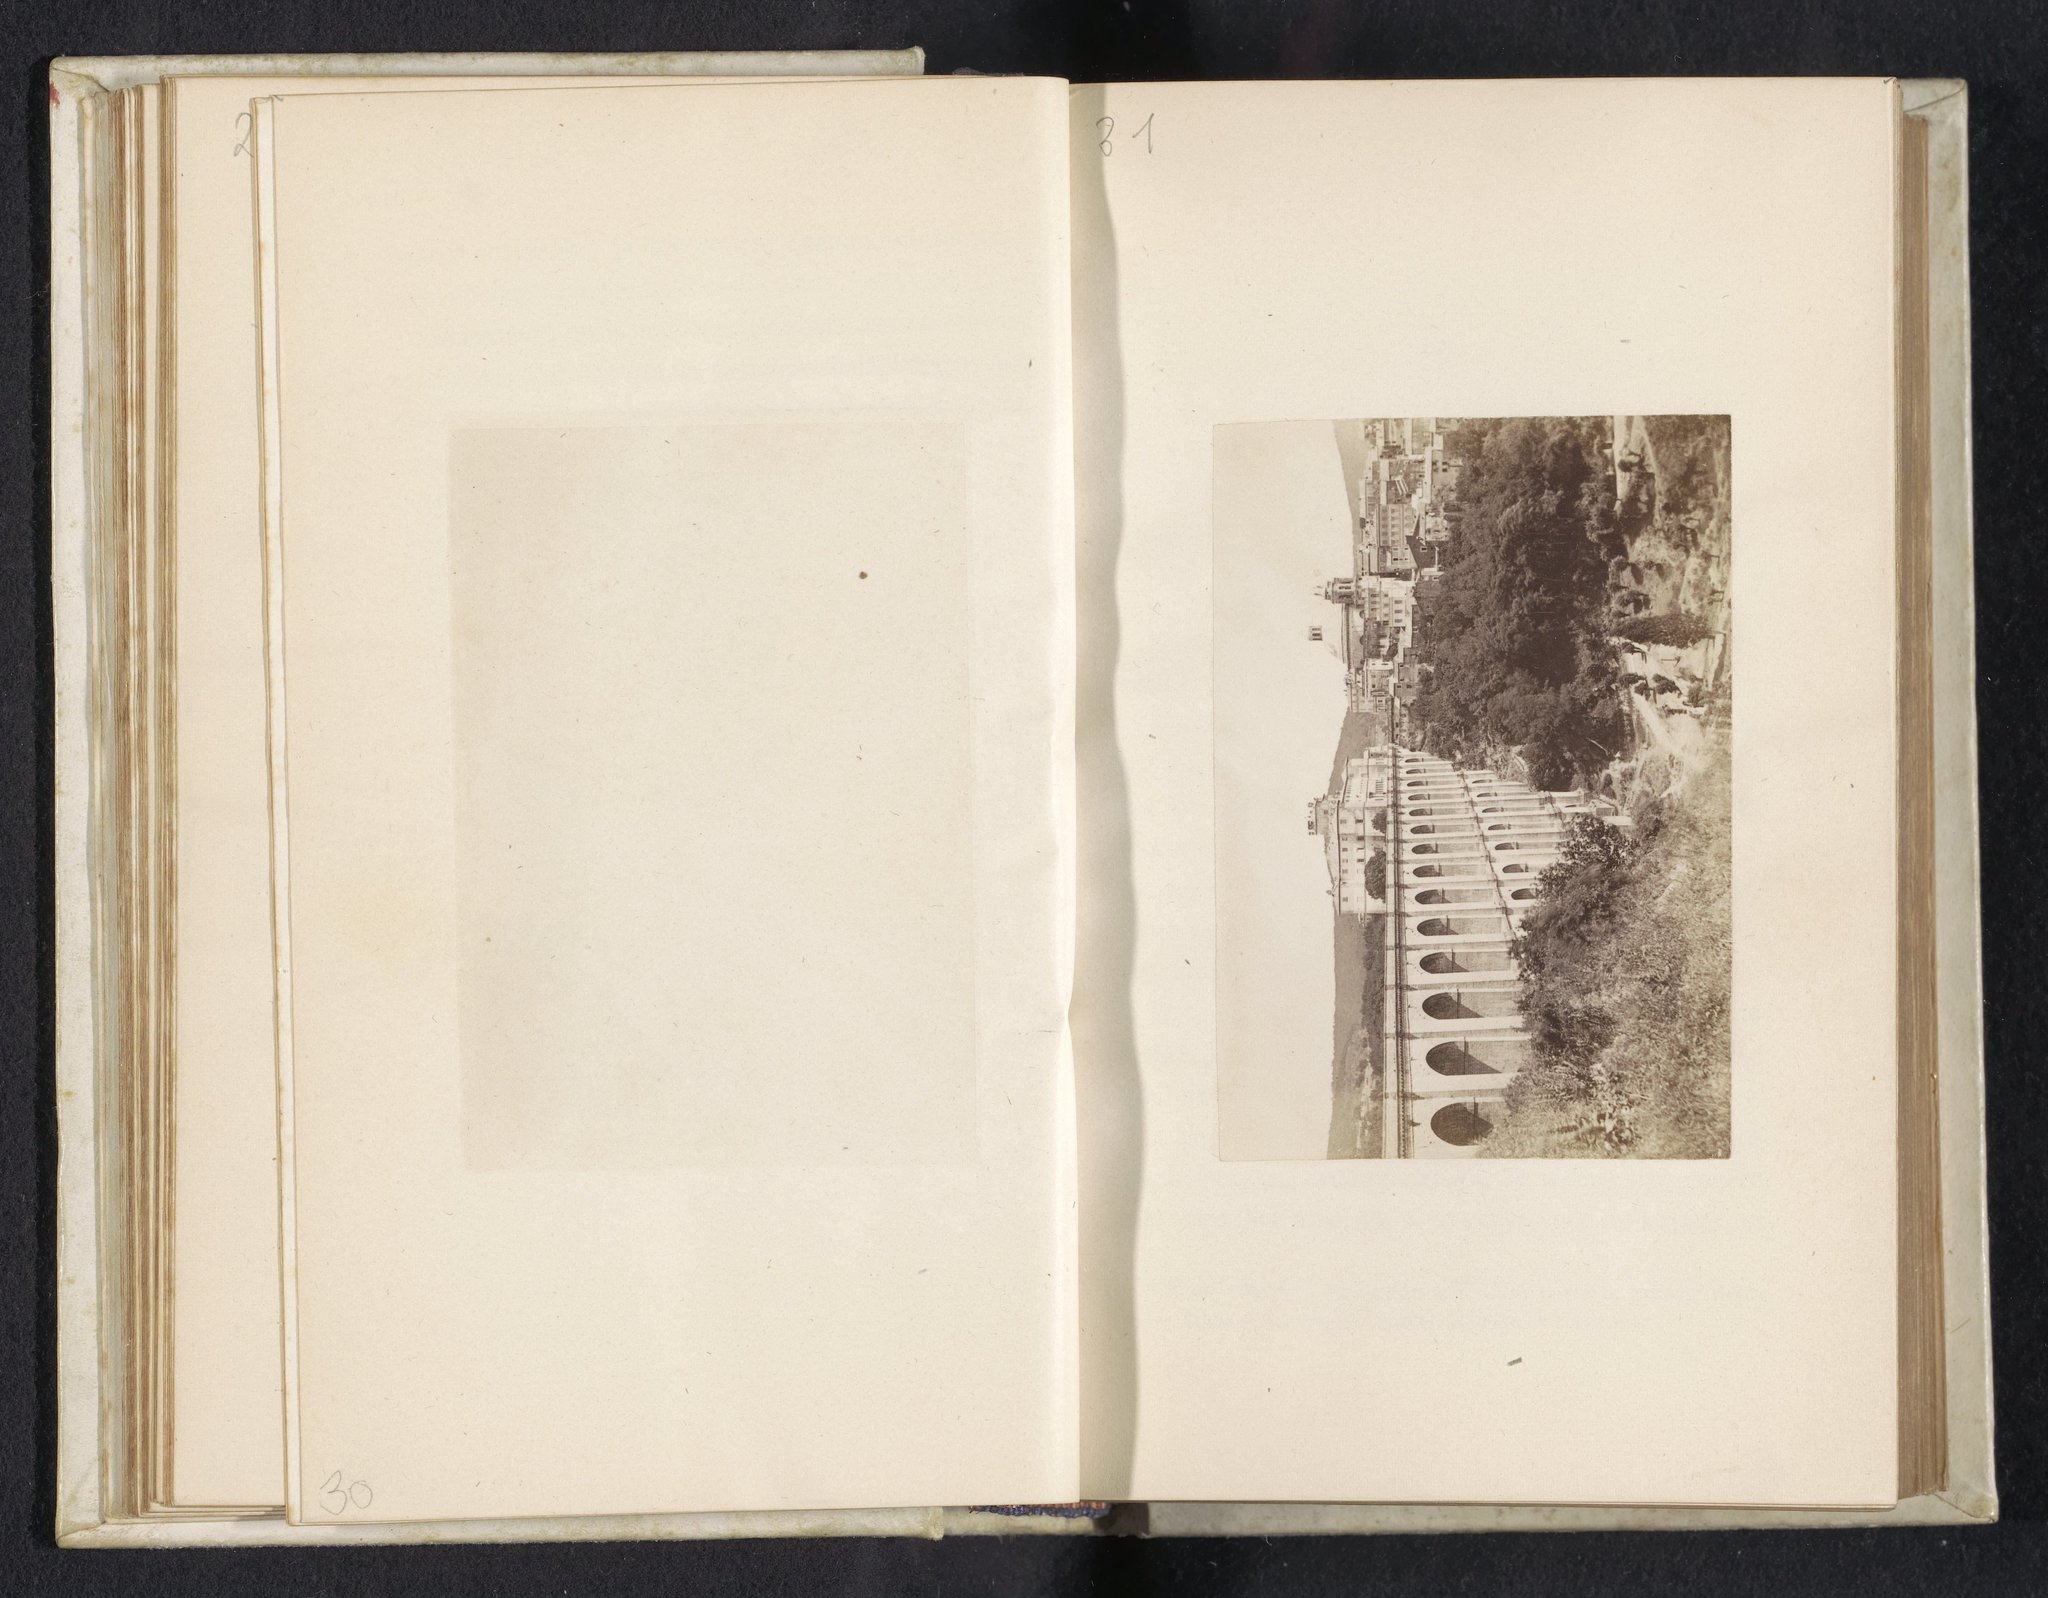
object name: photograph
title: Gezicht op Ariccia, met op de voorgrond een aquaduct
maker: Anonymous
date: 1850-1860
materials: photographic support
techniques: albumen print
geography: lazio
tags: city-view in general; 'veduta', landscape with bridge, viaduct or aqueduct